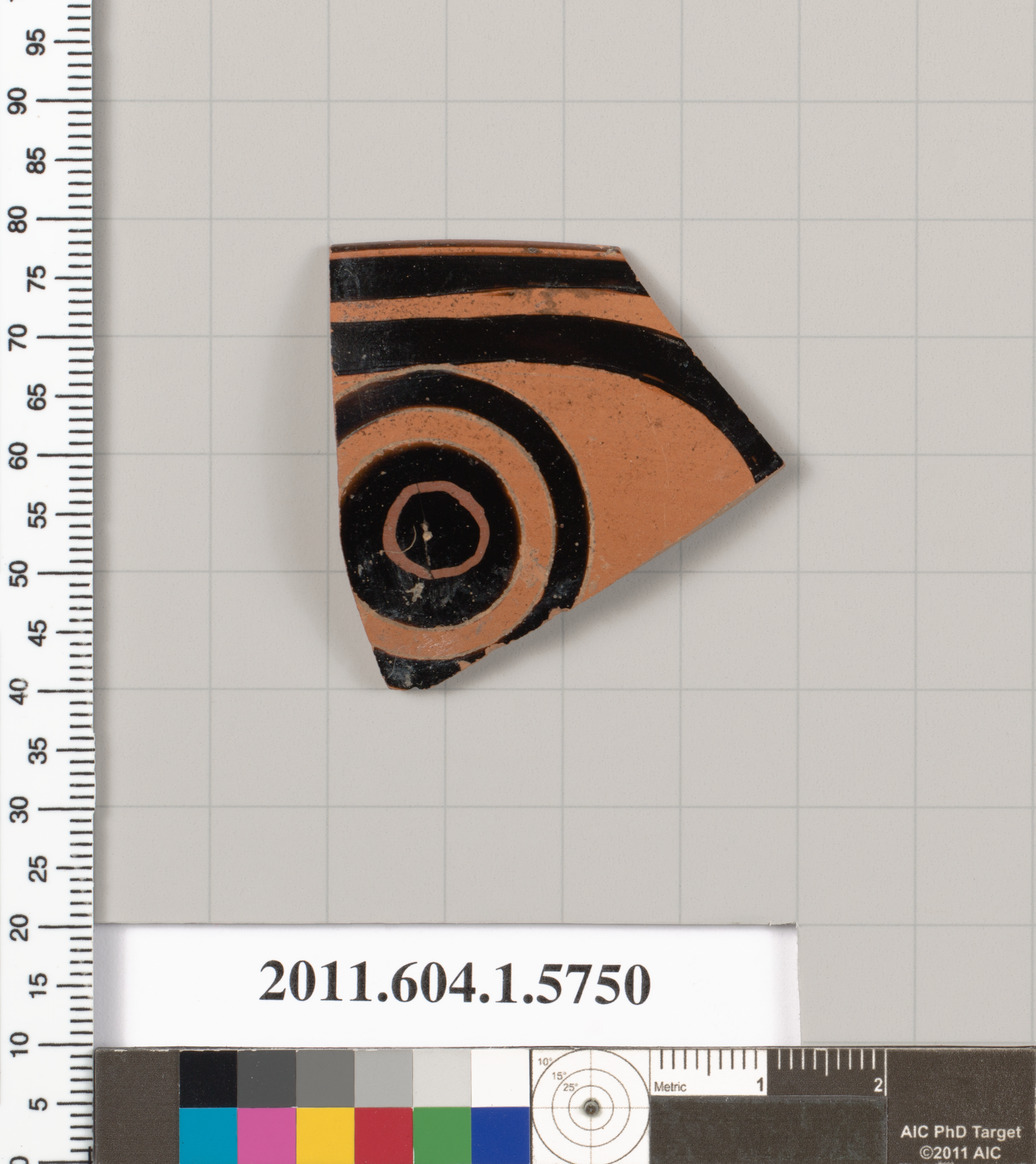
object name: kylix fragment, eye cup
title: Terracotta rim fragment of a kylix: eye-cup (drinking cup)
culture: greek, attic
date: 525-515 BCE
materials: terracotta